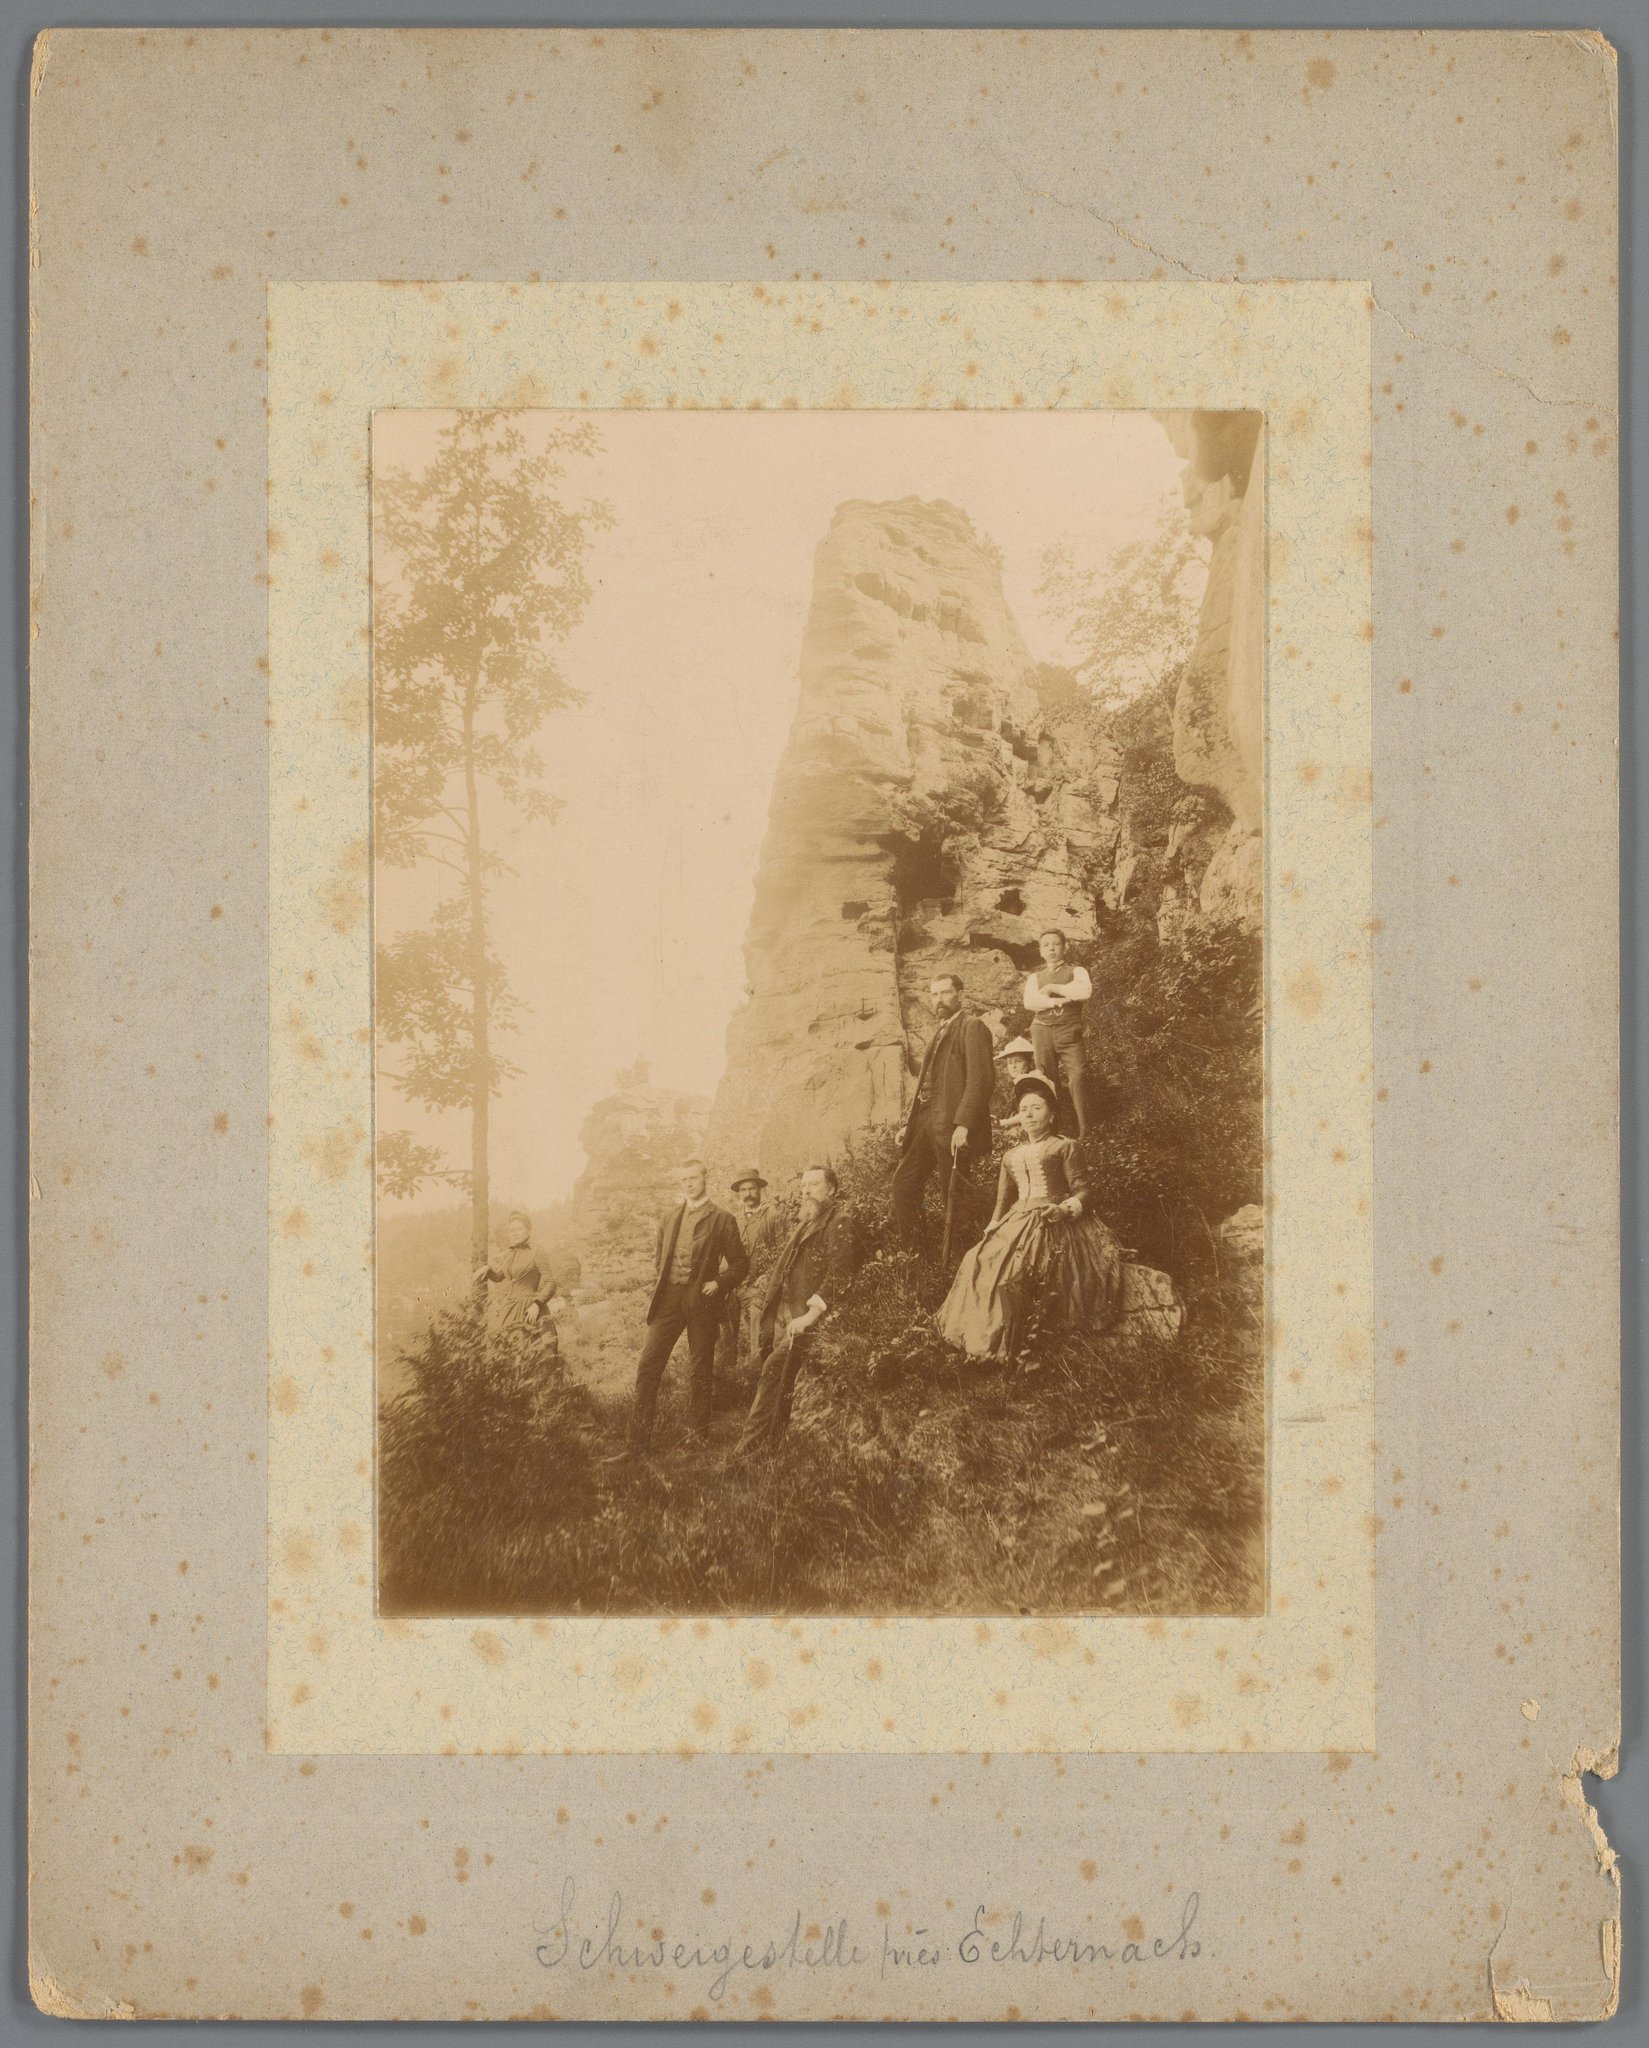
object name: photograph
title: Schweigestelle près Echternach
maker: Anonymous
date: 1880-1910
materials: cardboard, photographic support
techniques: gelatin silver print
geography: echternach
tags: adult man (+ five persons), adult woman (+ two persons), rock-formations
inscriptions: inscription: ‘A3 - Schweigestelle’